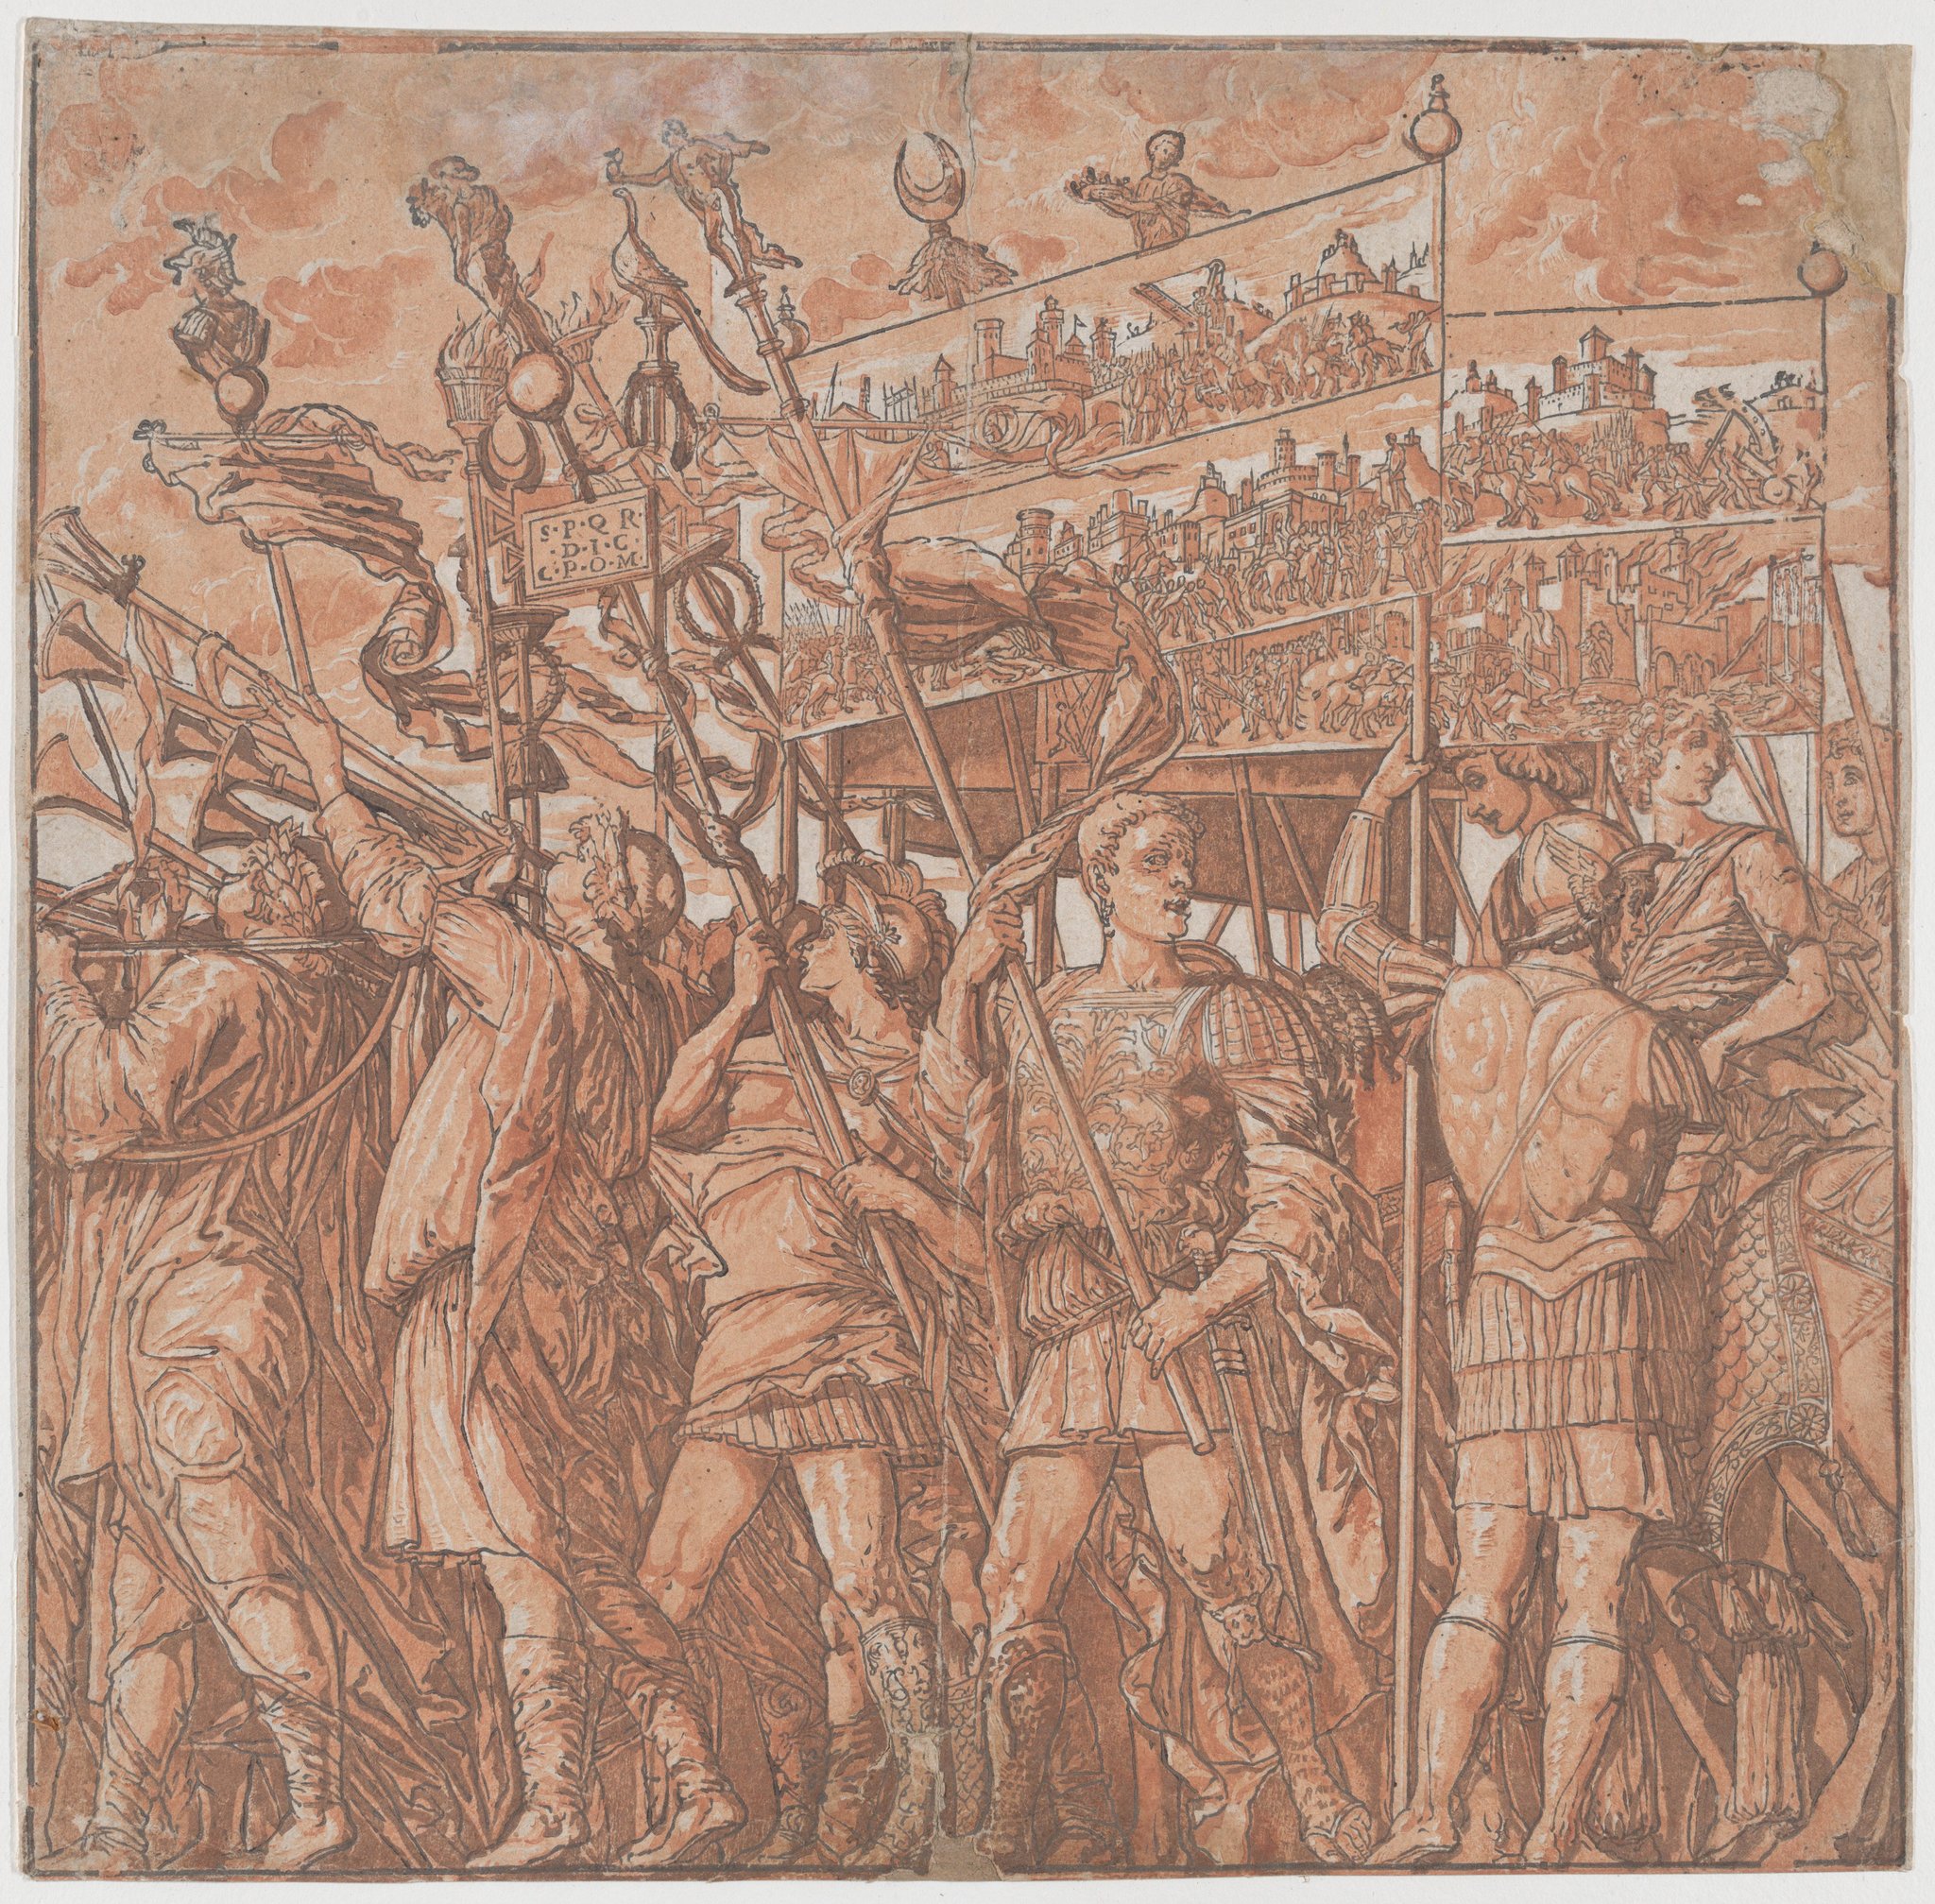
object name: print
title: Sheet 1: Roman soldiers carrying banners depicting the triumphant victories of Julius Caesar, from "The Triumph of Julius Caesar"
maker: andrea andreani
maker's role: artist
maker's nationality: italian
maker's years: 1558-1629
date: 1599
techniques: woodcut, printing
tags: soldiers,flags